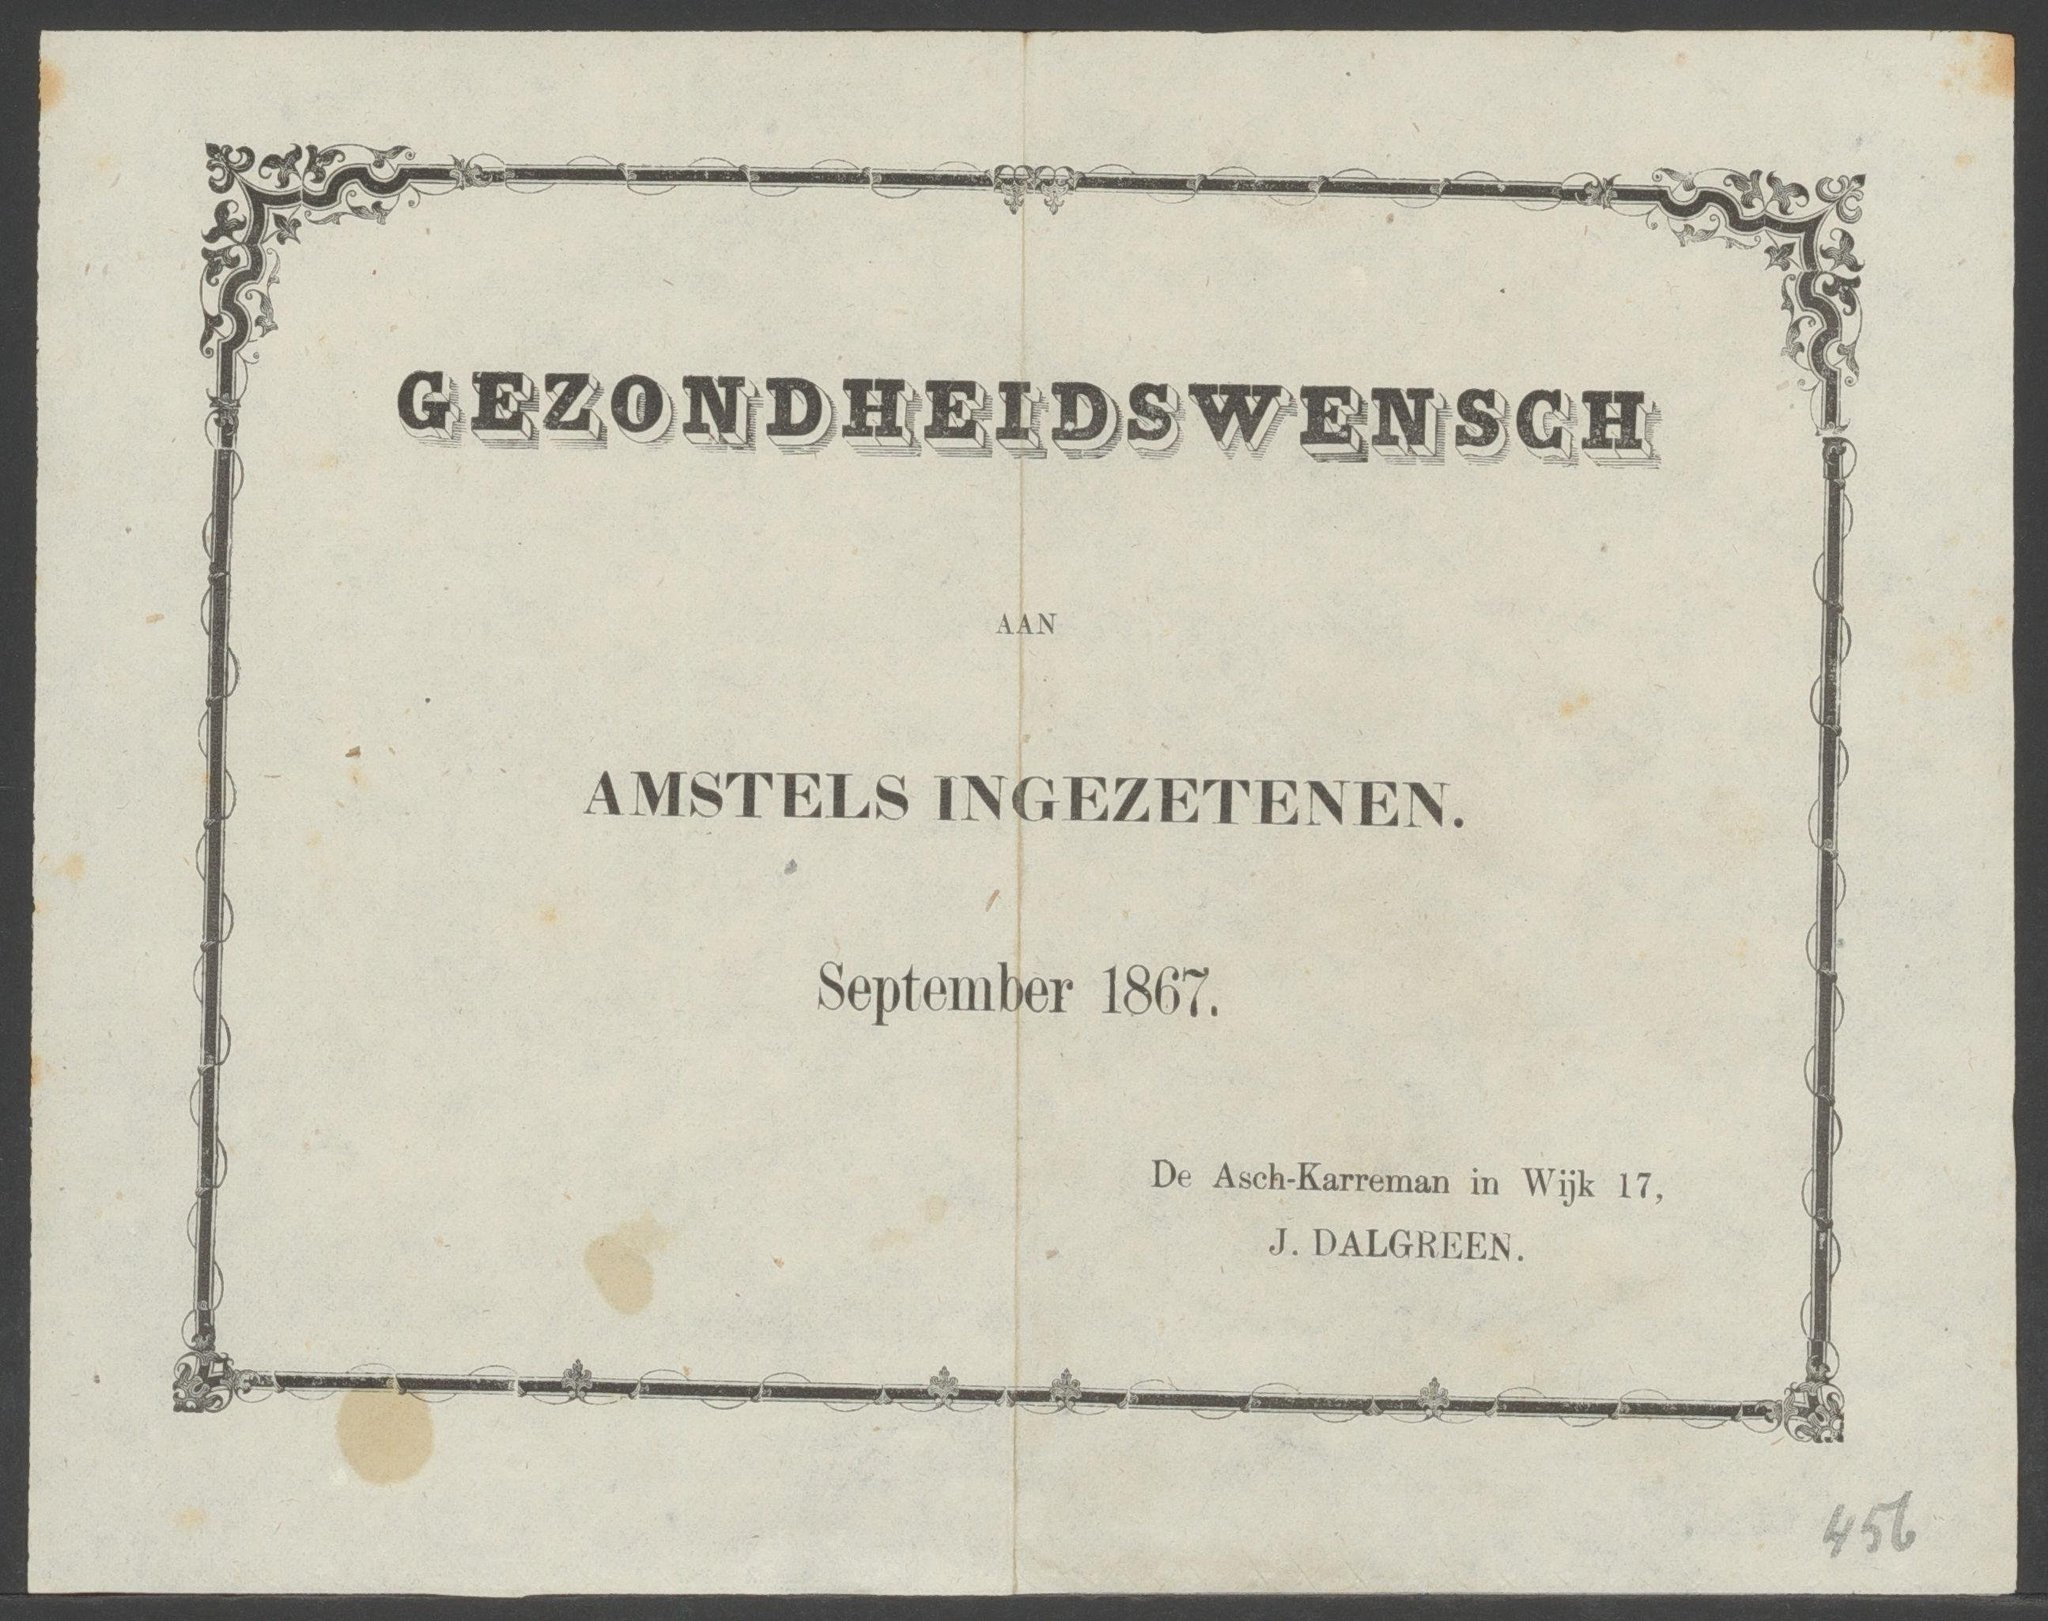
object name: fair print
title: Kermisprent van de Amsterdamse askarrenmannen voor het jaar 1867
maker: Anonymous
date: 1867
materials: paper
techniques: letterpress printing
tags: garbage collection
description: Kermisprent namens de askarrenmannen (karrenman of vuilnisman) te Amsterdam, september 1867. Namens J. Dalgreen, de askarreman van wijk no. 17. Onderwerpsrubrieken binnen de Atlas Zeden en Gewoonten: Zeden en gewoonten in engeren zin, Volksleven, Volksbladen, Nieuwjaars- en Kerstwenschen, Amsterdam.